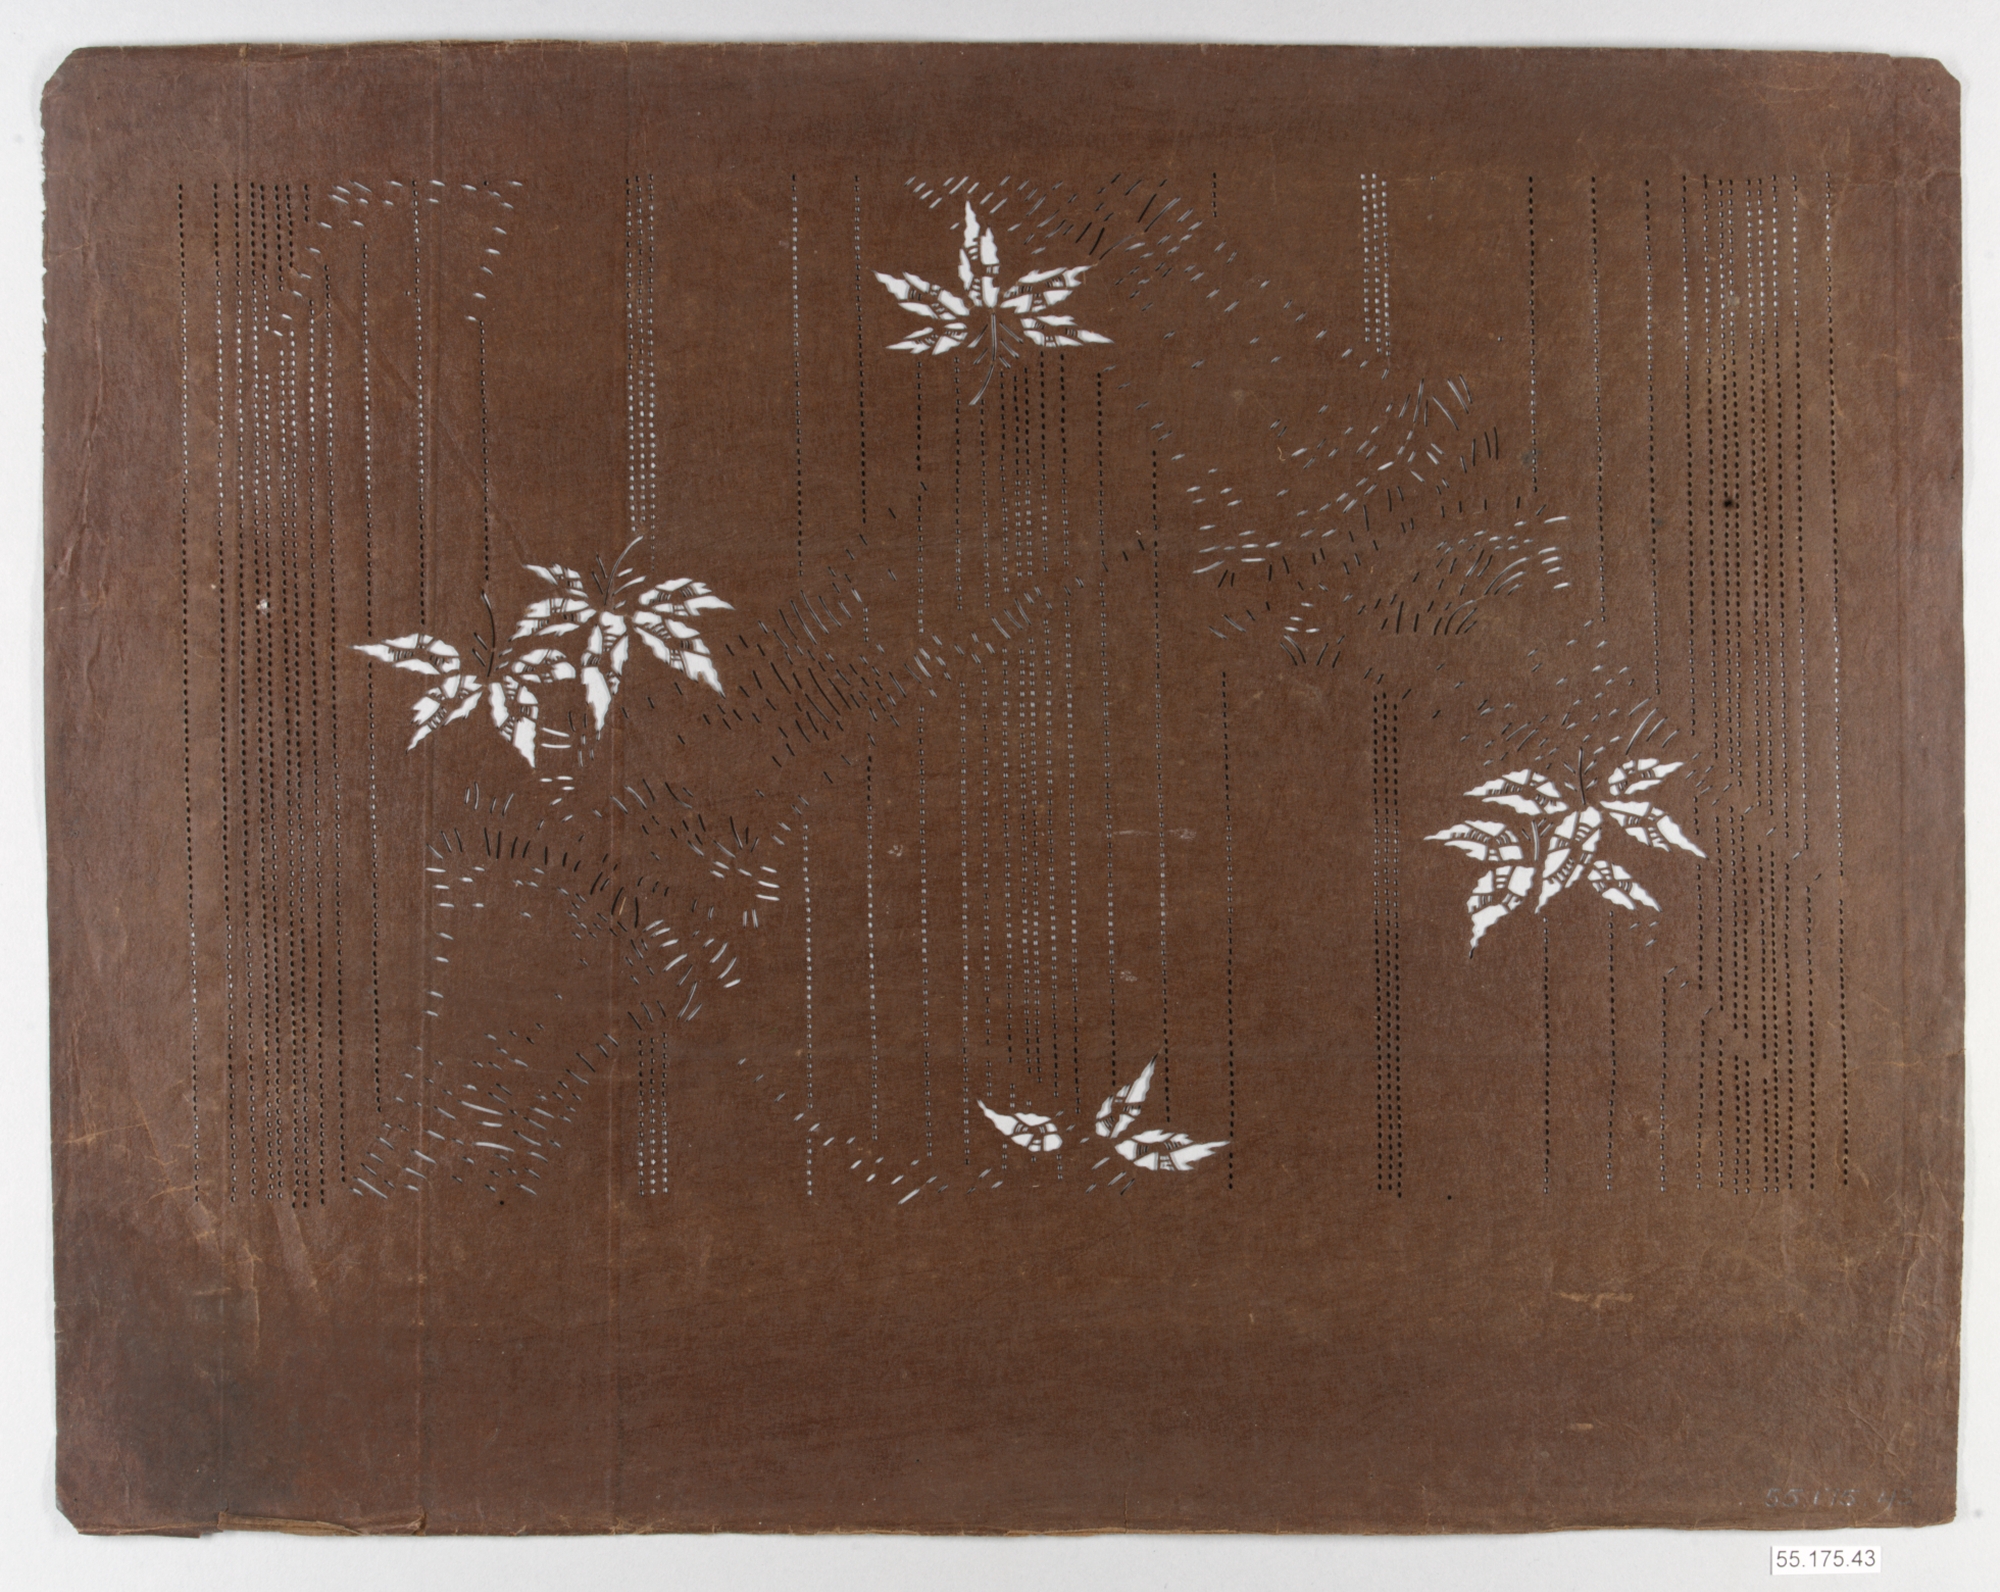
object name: stencil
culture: japanese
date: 1801-1900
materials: paper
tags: leaves